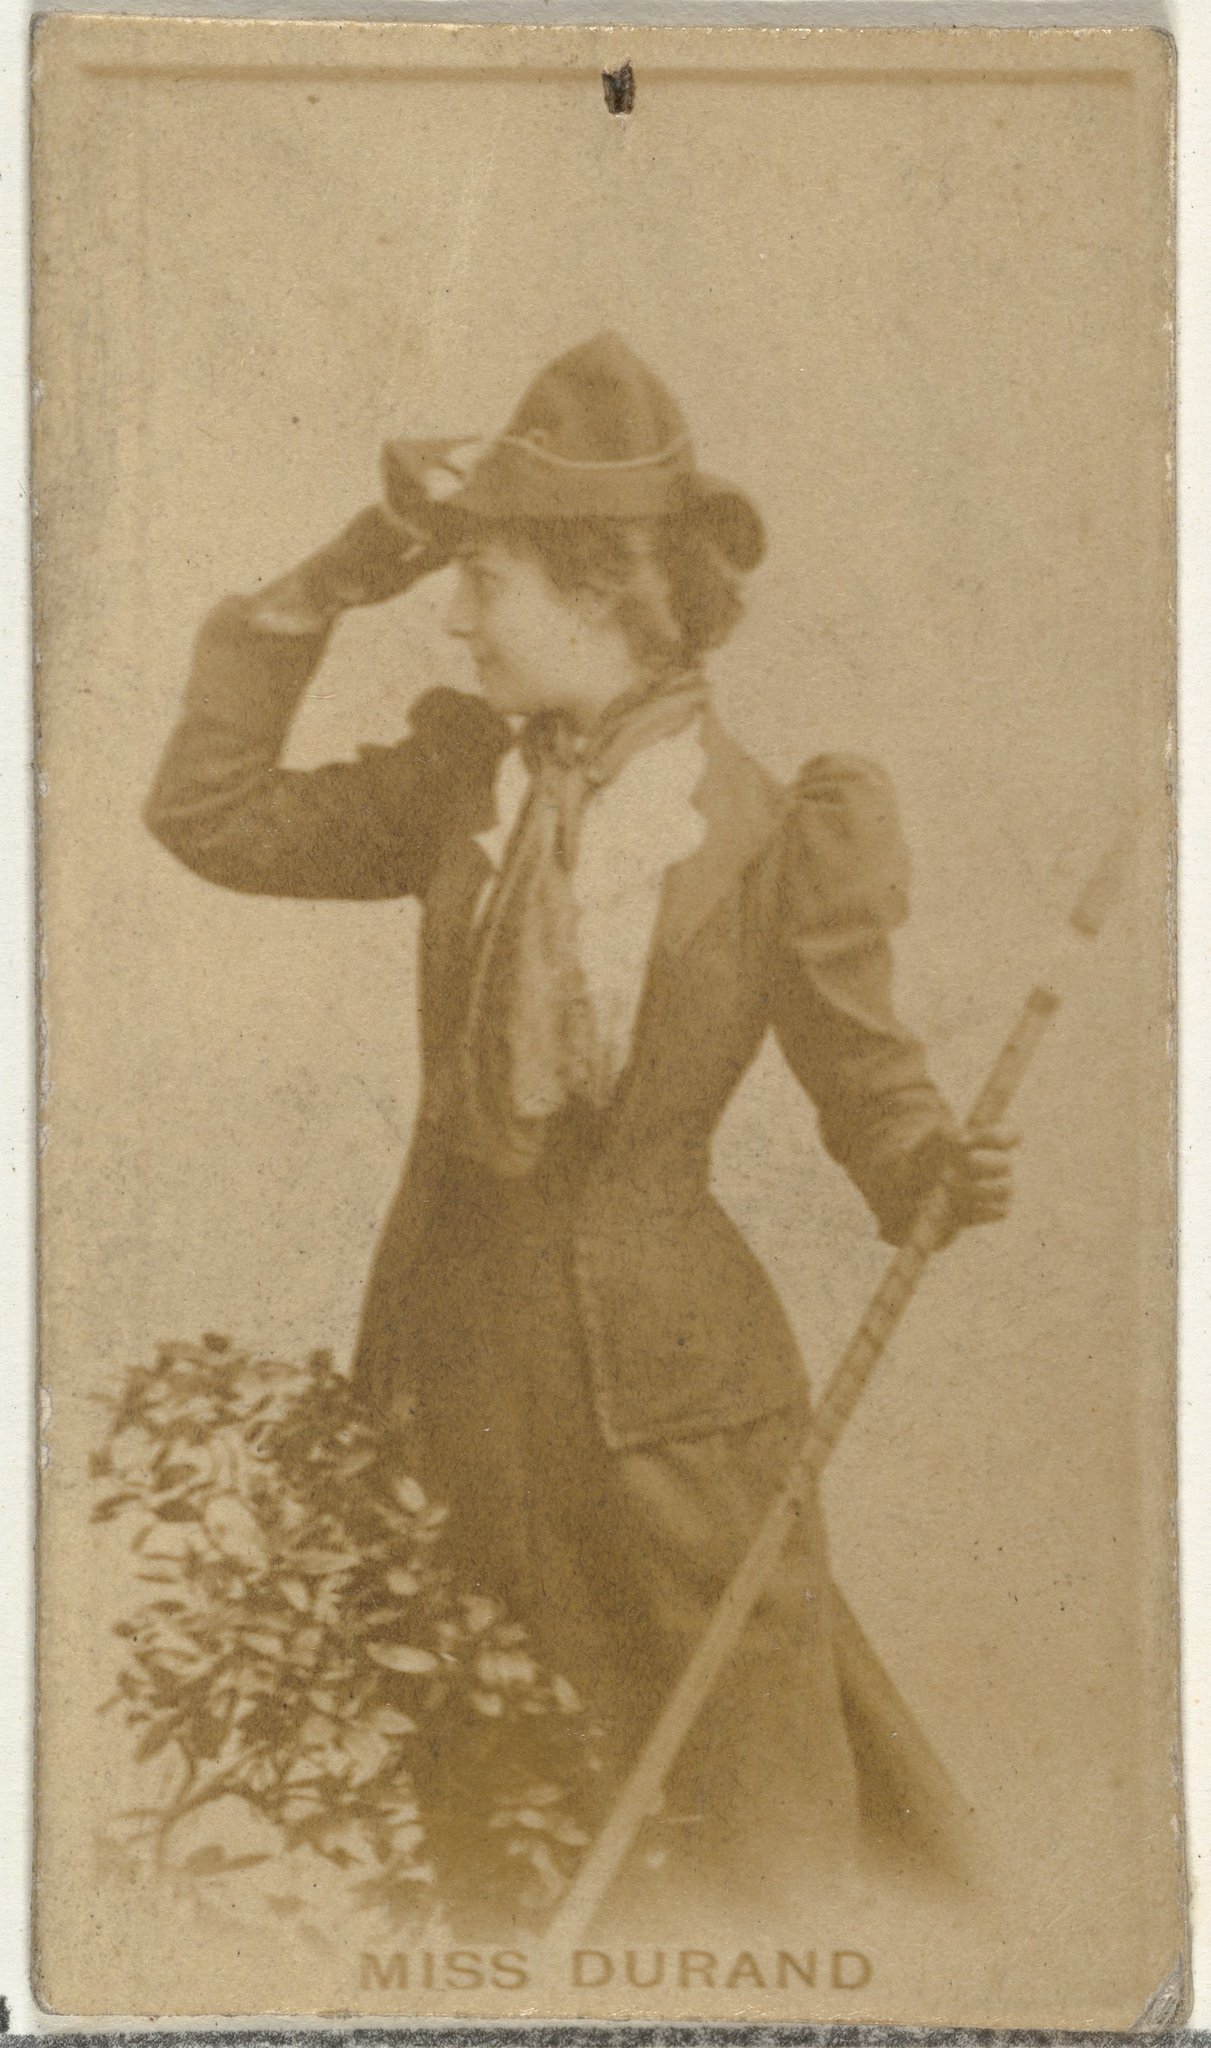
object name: photograph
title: Miss Durand, from the Actors and Actresses series (N145-8) issued by Duke Sons & Co. to promote Duke Cigarettes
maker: w. duke, sons & co.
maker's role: publisher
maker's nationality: american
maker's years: 1870-1920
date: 1891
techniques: albumen silver print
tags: portraits,women,actresses